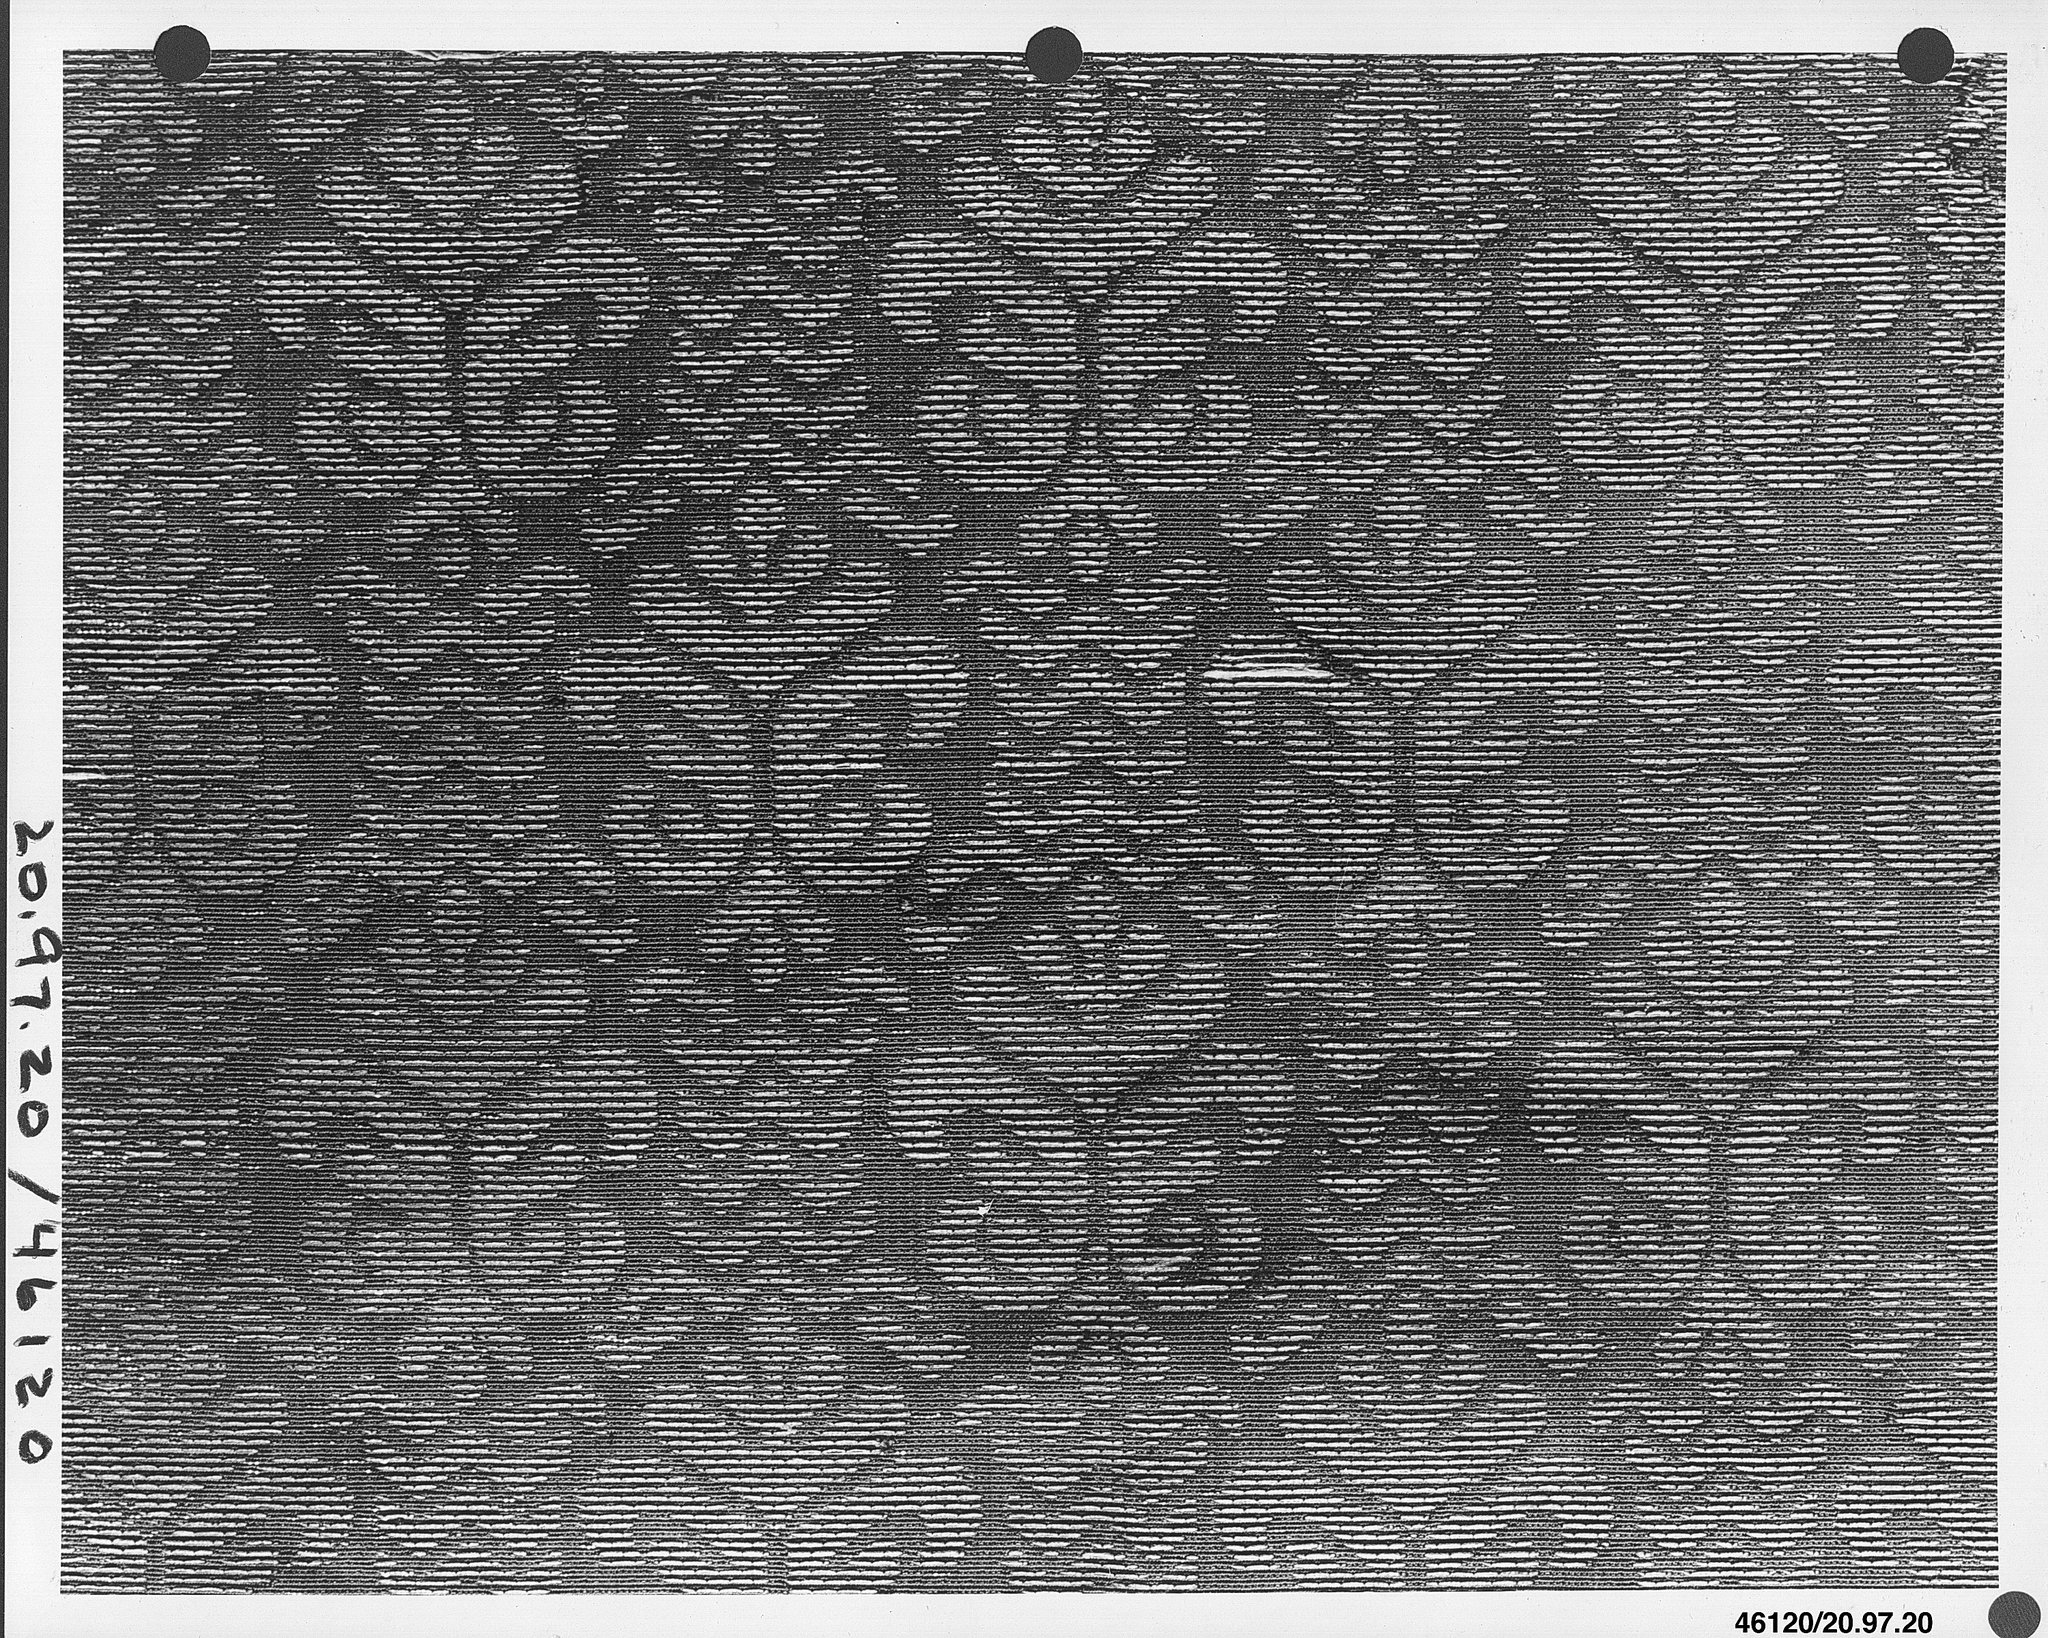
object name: piece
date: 1501-1700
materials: metal thread, silk